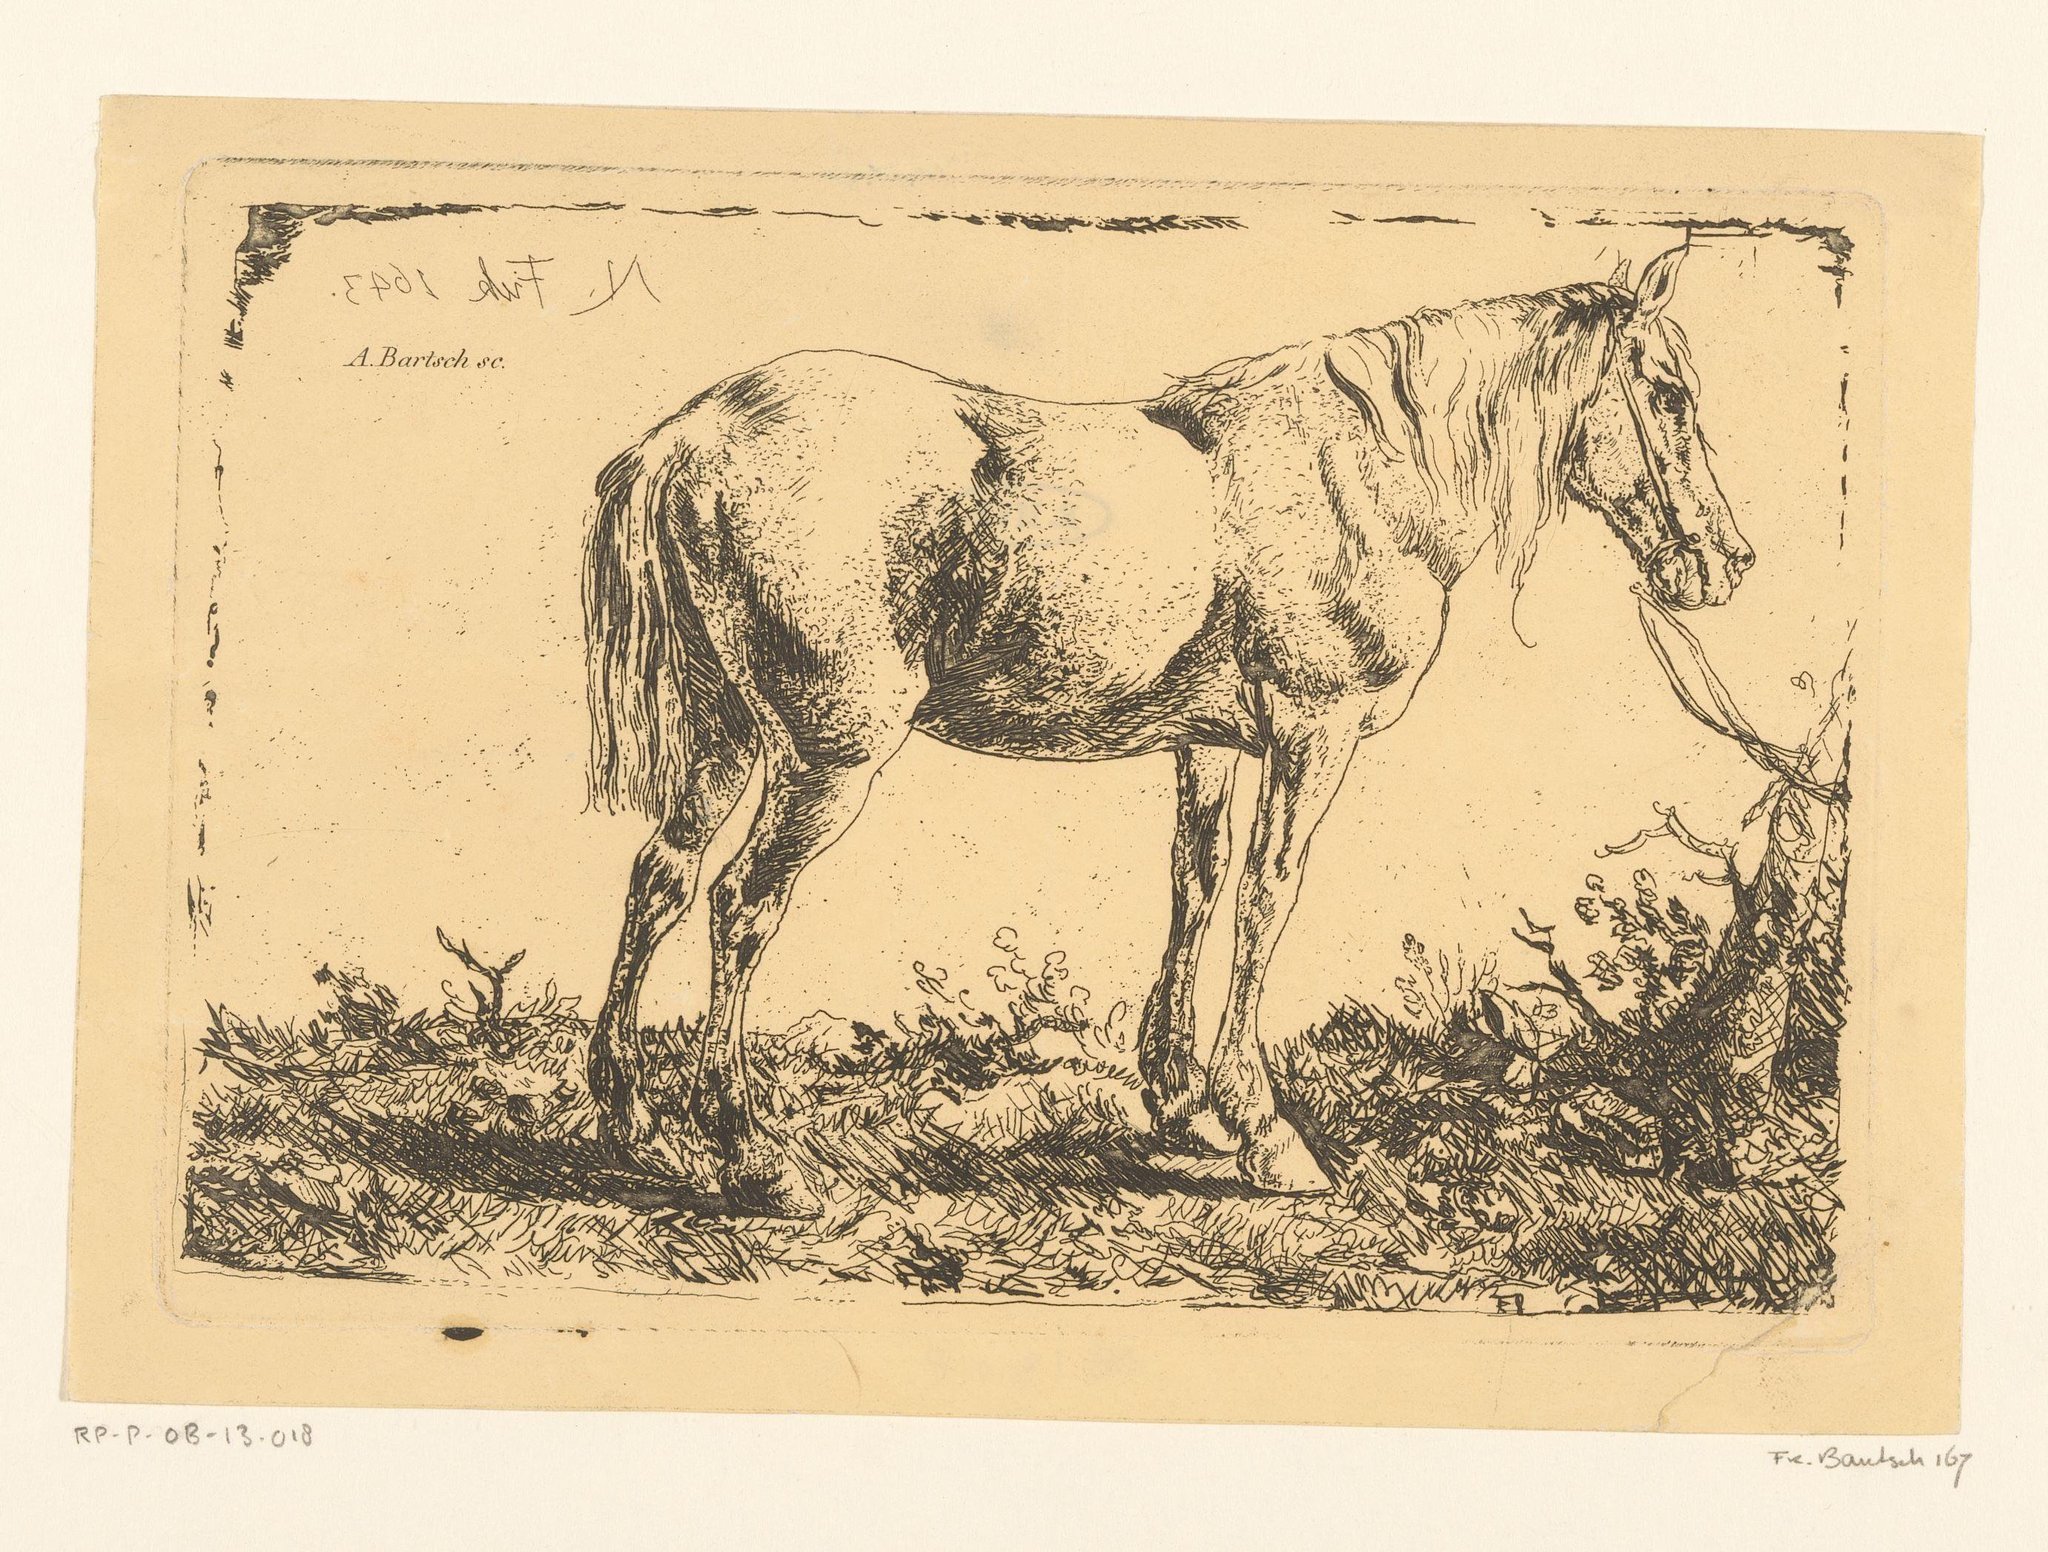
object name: print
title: Paard aan een boom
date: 1803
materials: paper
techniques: etching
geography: vienna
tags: horses and kindred animals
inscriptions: collector's mark: Lugt 2228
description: Mogelijk afkomstig uit het album: Copies faites d'après des estampes très rares (...) décrites dans les volumes I. IV. et V. du peintre graveur, par Adam Bartsch (RP-P-OB-13.069).